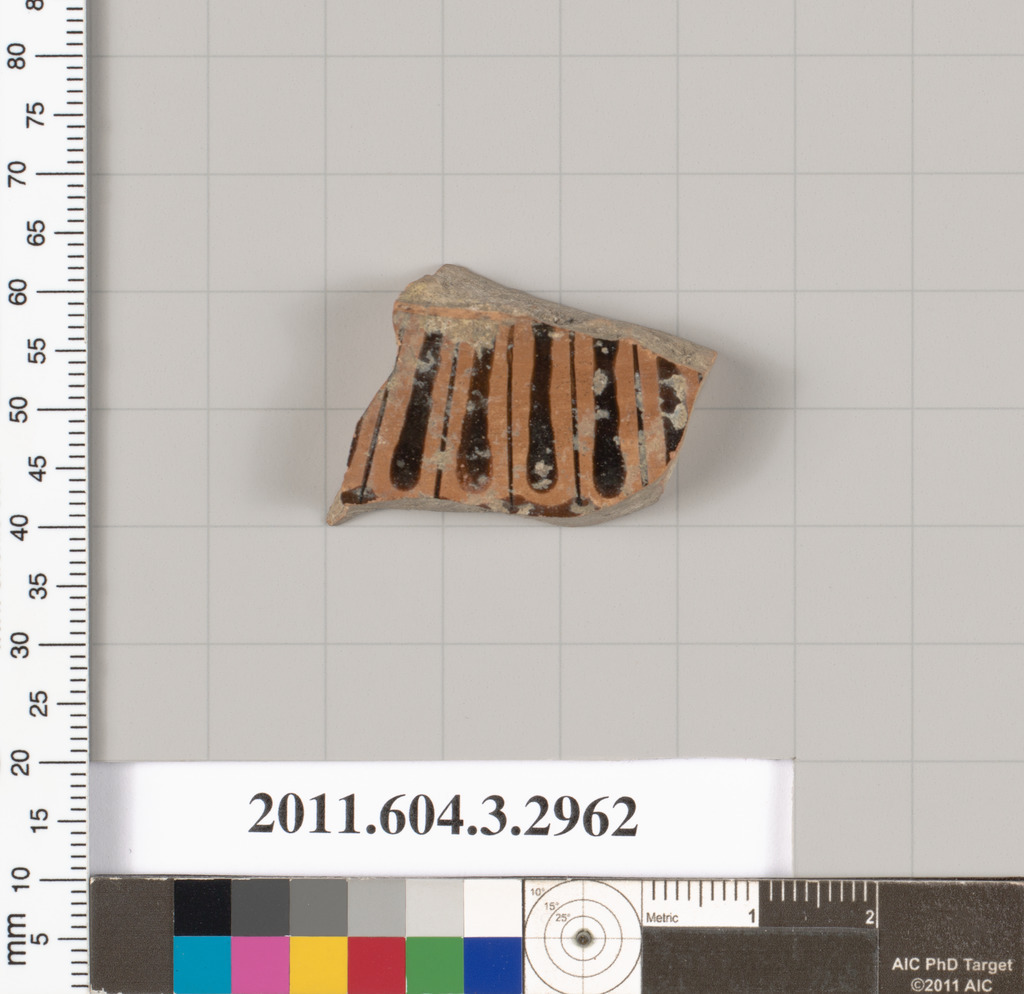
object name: neck amphora fragment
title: Terracotta fragment of a neck-amphora (jar)?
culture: greek, attic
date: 534-468 BCE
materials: terracotta